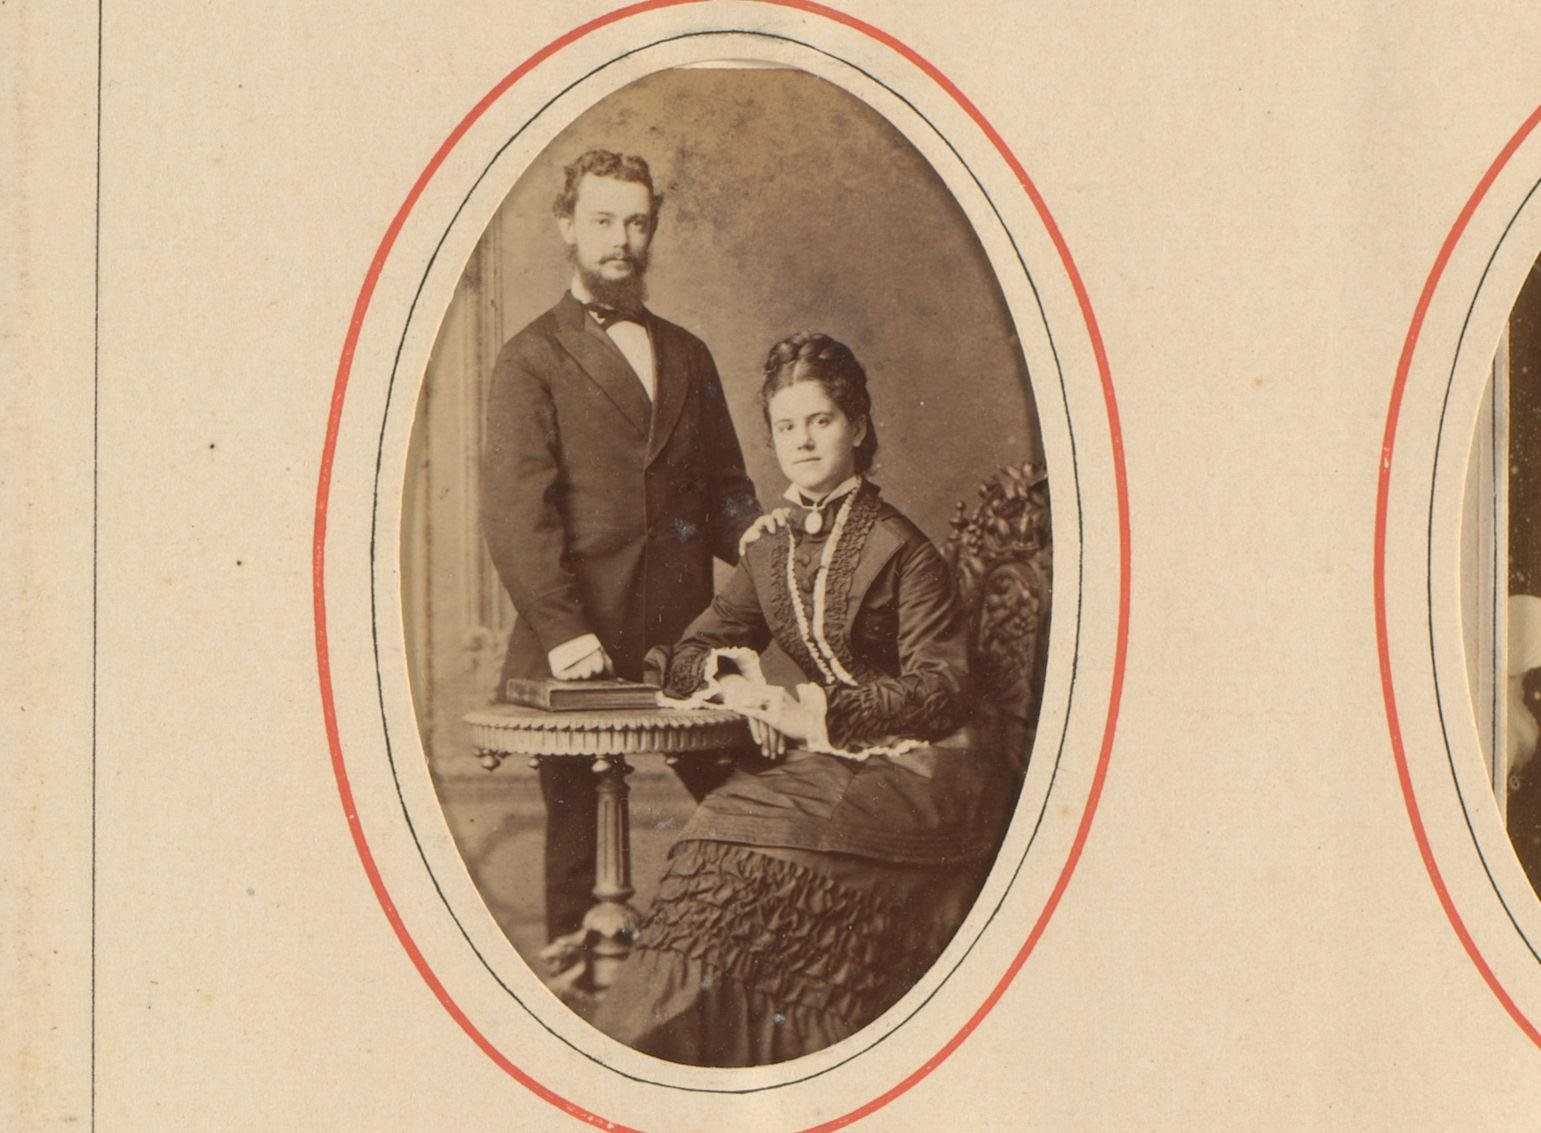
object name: album leaf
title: Portret van een onbekende man en vrouw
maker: bernardus bruining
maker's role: fotograaf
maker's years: 1834-1900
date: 1875-1877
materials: cardboard, paper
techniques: albumen print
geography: leiden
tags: anonymous historical persons portrayed in a double portrait